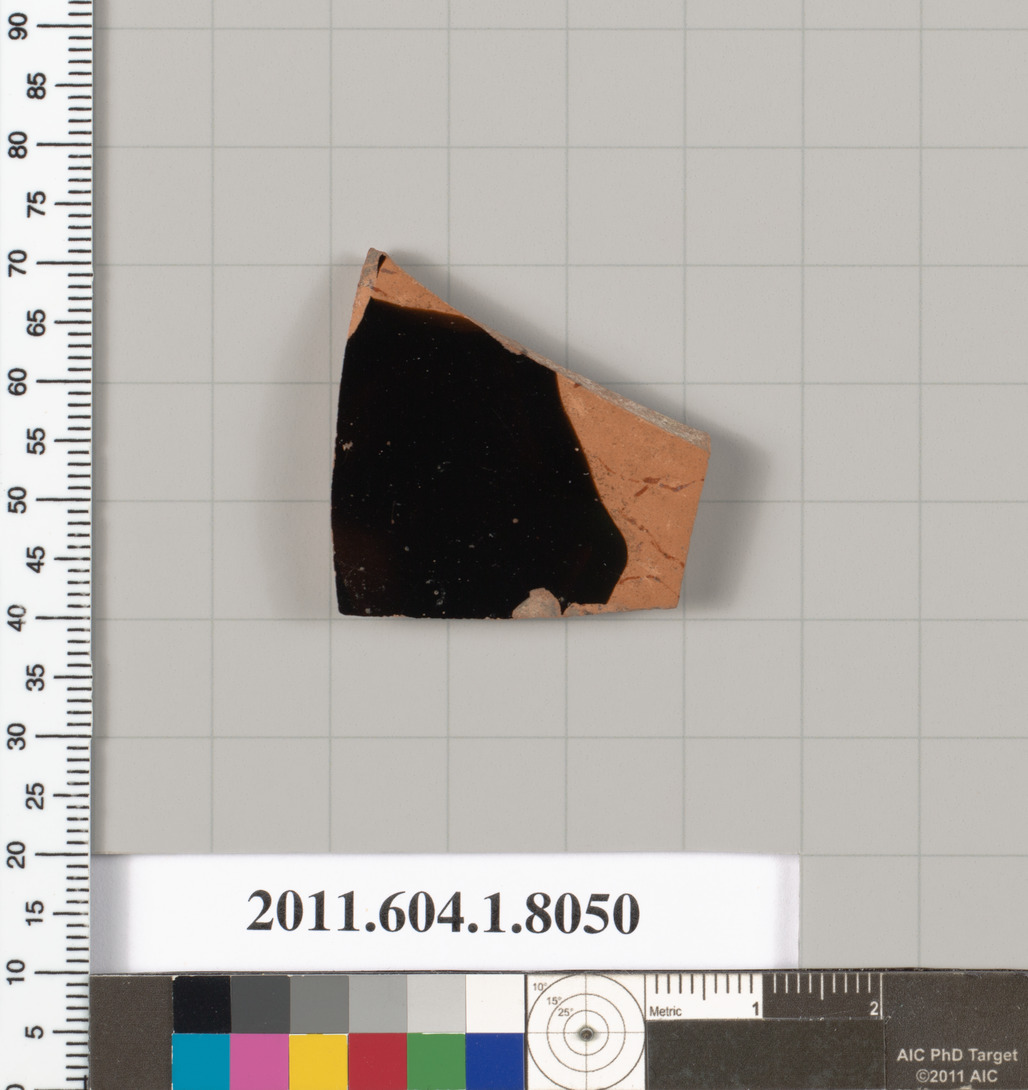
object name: kylix fragment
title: Terracotta fragment of a kylix (drinking cup)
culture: greek, attic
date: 510-490 BCE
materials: terracotta